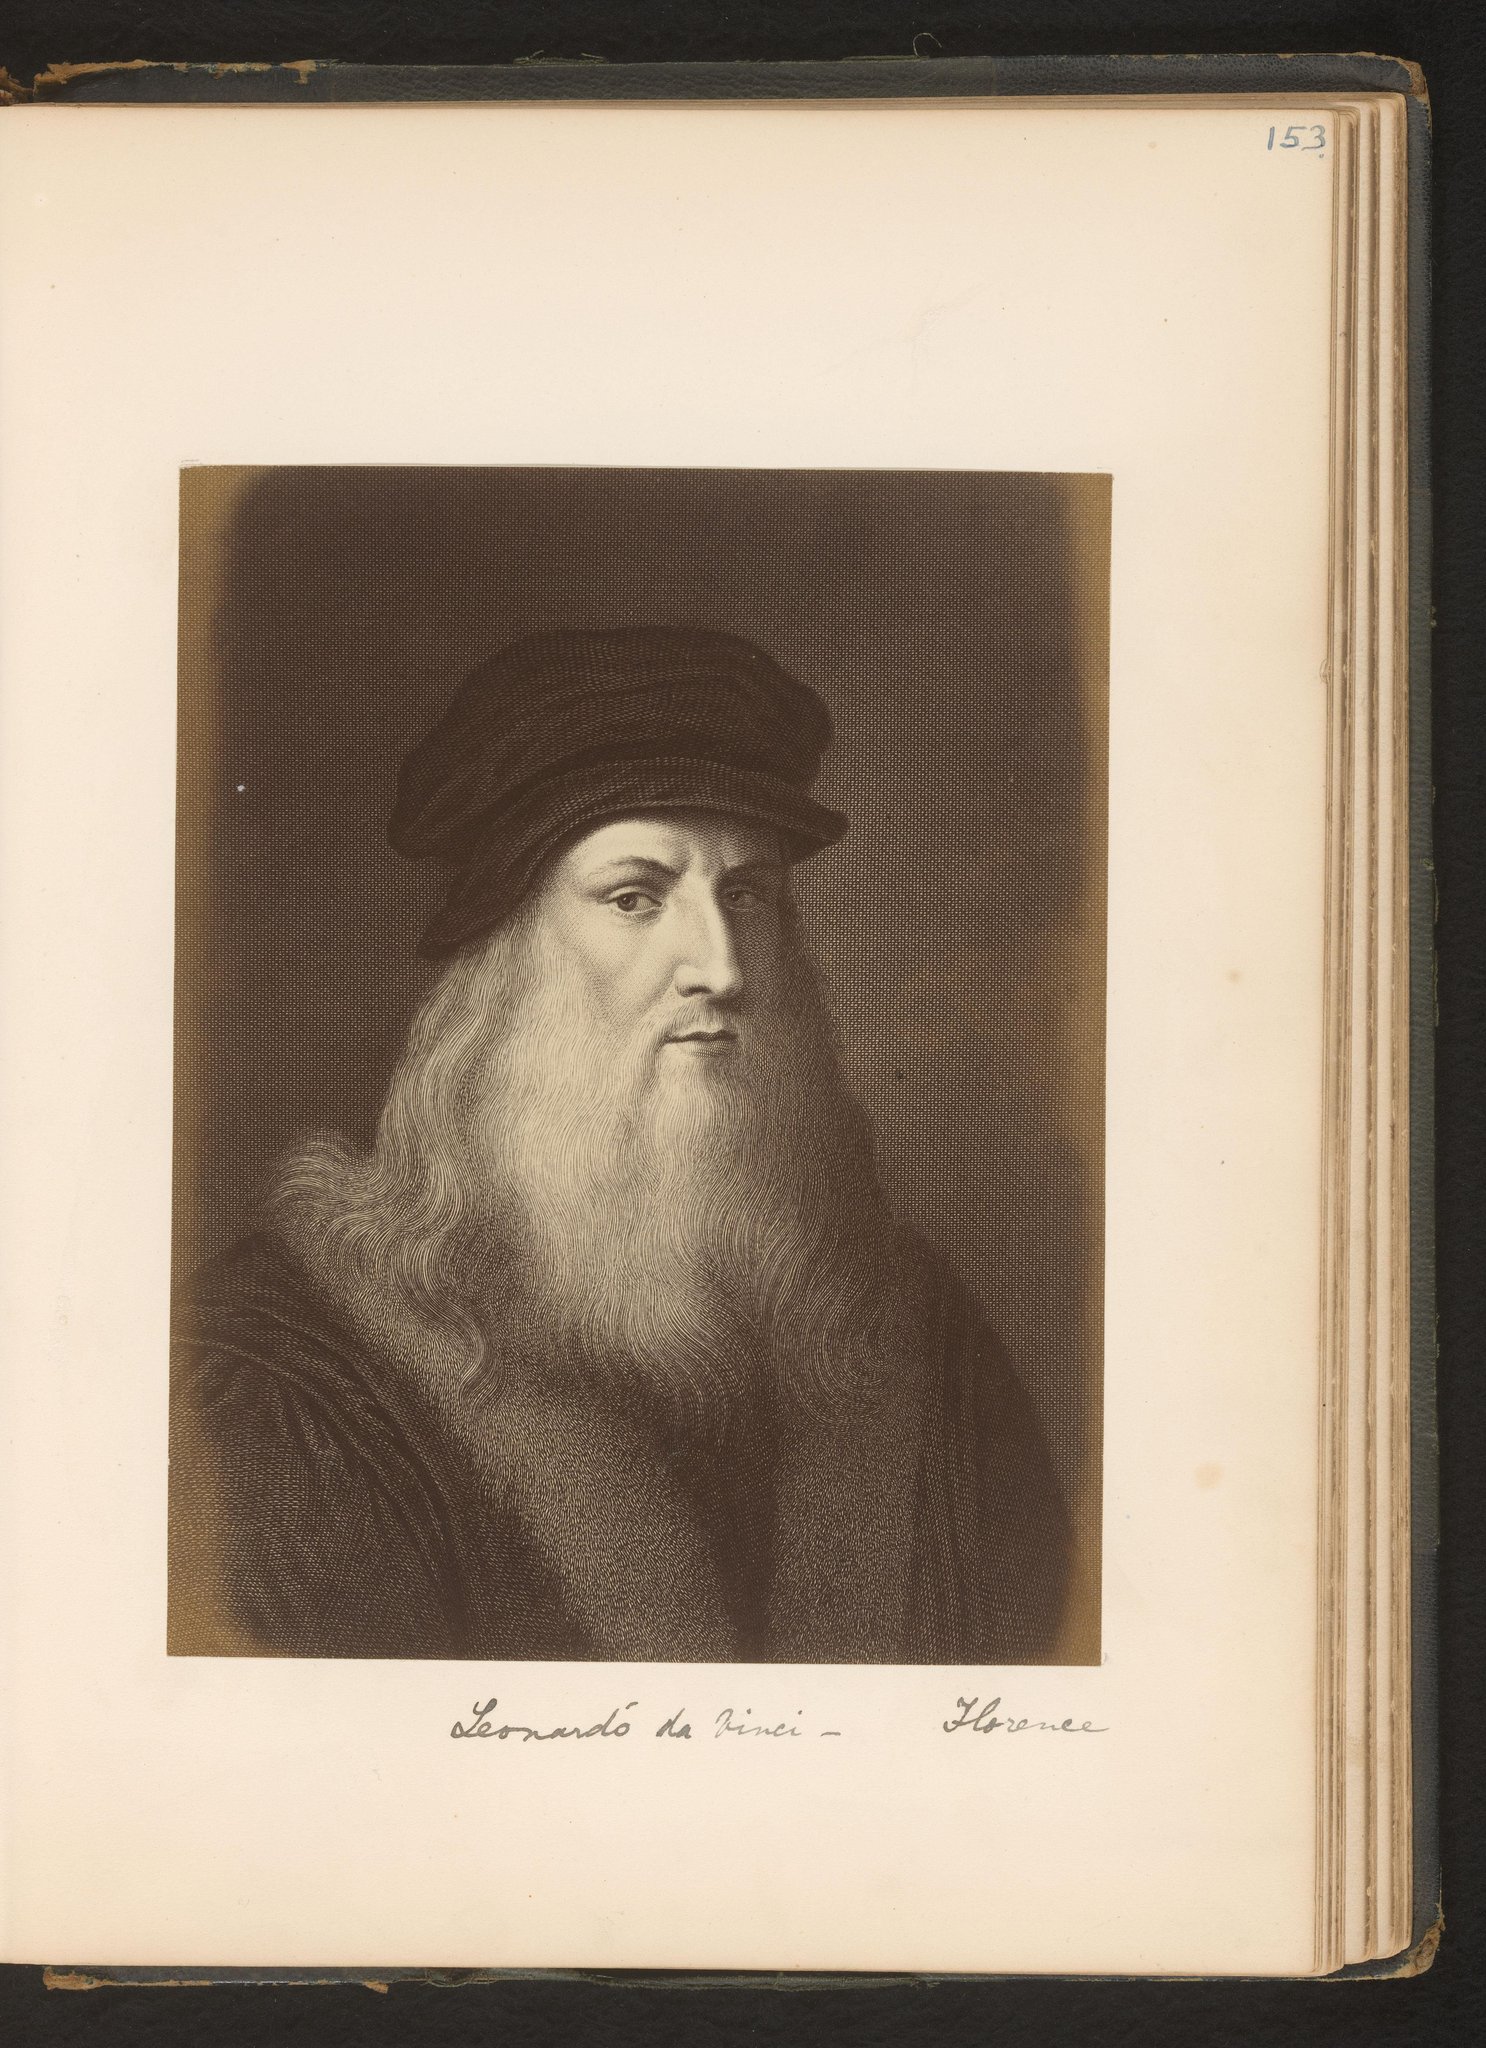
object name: album leaf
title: Fotoreproductie van een prent; een zelfportret van Leonardo da Vinci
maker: Anonymous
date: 1810-1873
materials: paper, photographic support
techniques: albumen print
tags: artist, leonardo da vinci, print, e.g.: engraving, etching, lithograph, portrait, self-portrait of artist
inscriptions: annotation: ‘Leonardo da Vinci - Florence’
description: Deze pagina maakt deel uit van een album.